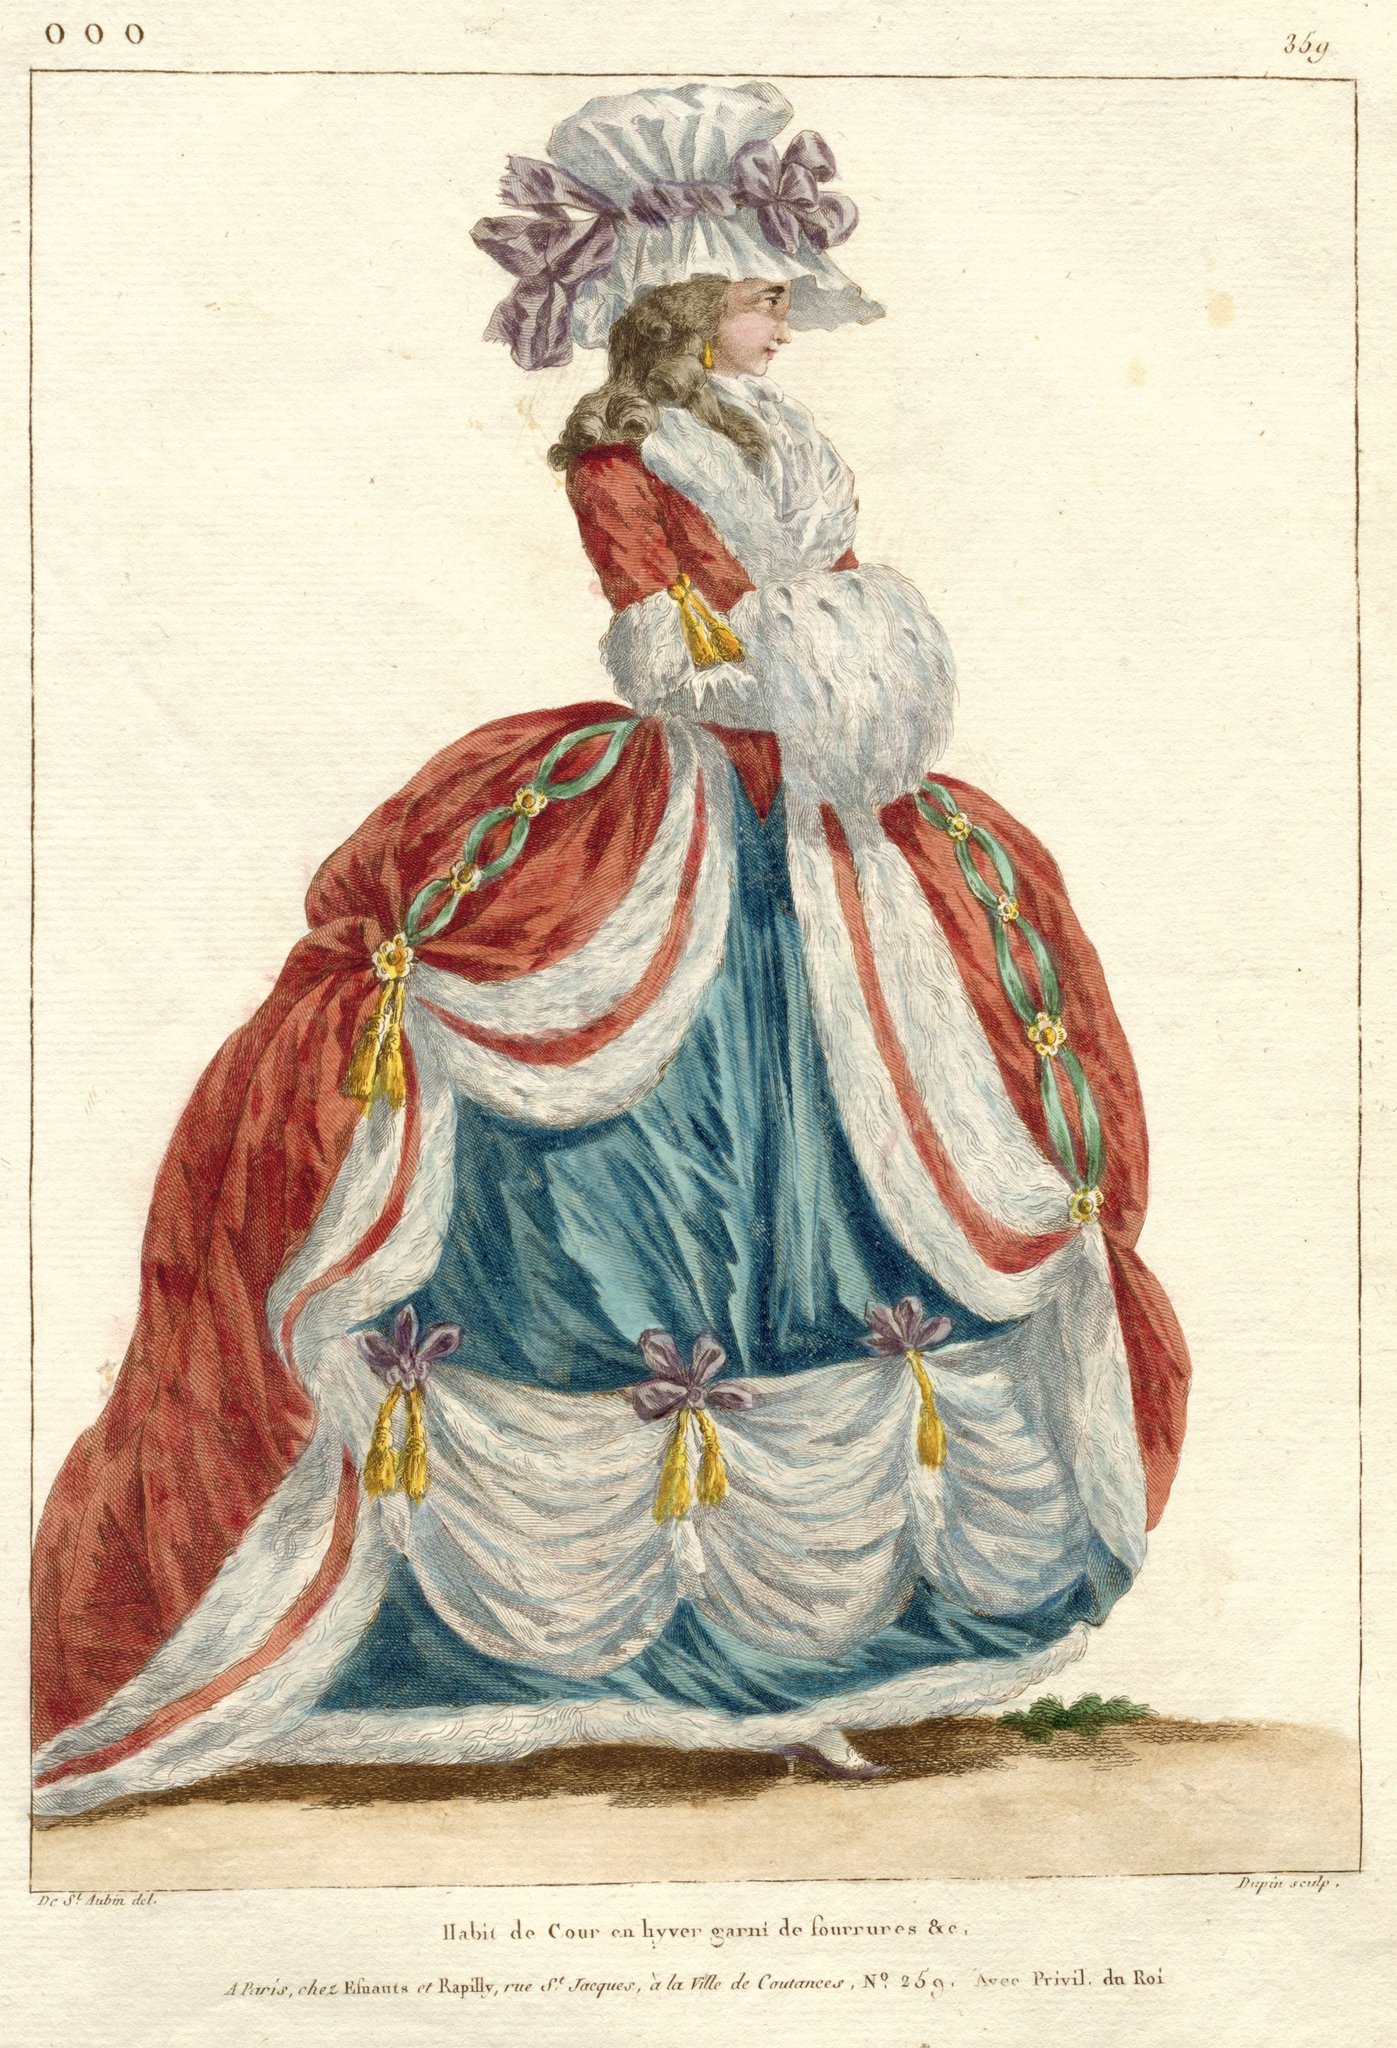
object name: fashion print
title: Marie Antoinette: The Queen of Fashion: Gallerie des Modes et Costumes Français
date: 1787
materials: paper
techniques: engraving, hand coloring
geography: paris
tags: dress, gown: court gown or court dress (+ women's clothes), head-gear: hat (+ textile fabrics used for clothes), styles of hairdress - aa - ~ women, head-gear: hat (+ women's clothes), muff (+ women's clothes)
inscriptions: signature: ‘Dupin sculp.’, address: ‘A Paris chez Esnauts et Rapilly, Rue de St. Jacques, a la Ville de Coutances, No. 259. Avec Privil du Roi.’, number: ‘359’, title: ‘Habit de Cour en hyver garni de fourrures & c.’, serial number: ‘o o o’, signature: ‘De St. Aubin del.’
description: French queens were expected to set an example in the realm of fashion. As the wife of Louis XVI, Marie Antoinette threw herself into this task with enthusiasm. Together with her marchande de modes Rose Bertin and her hairdresser Léonard, she launched many a new fashion. Court etiquette dictated robes de cour – lavishly embellished gowns with wide skirts. When receiving visitors, Marie Antoinette wore a robe à la polonaise 1 2, but preferred an informal, loose-fitting gown when at her own pavilion in Versailles. This chemise de la reine 3 was quickly adopted by other women of the elite.